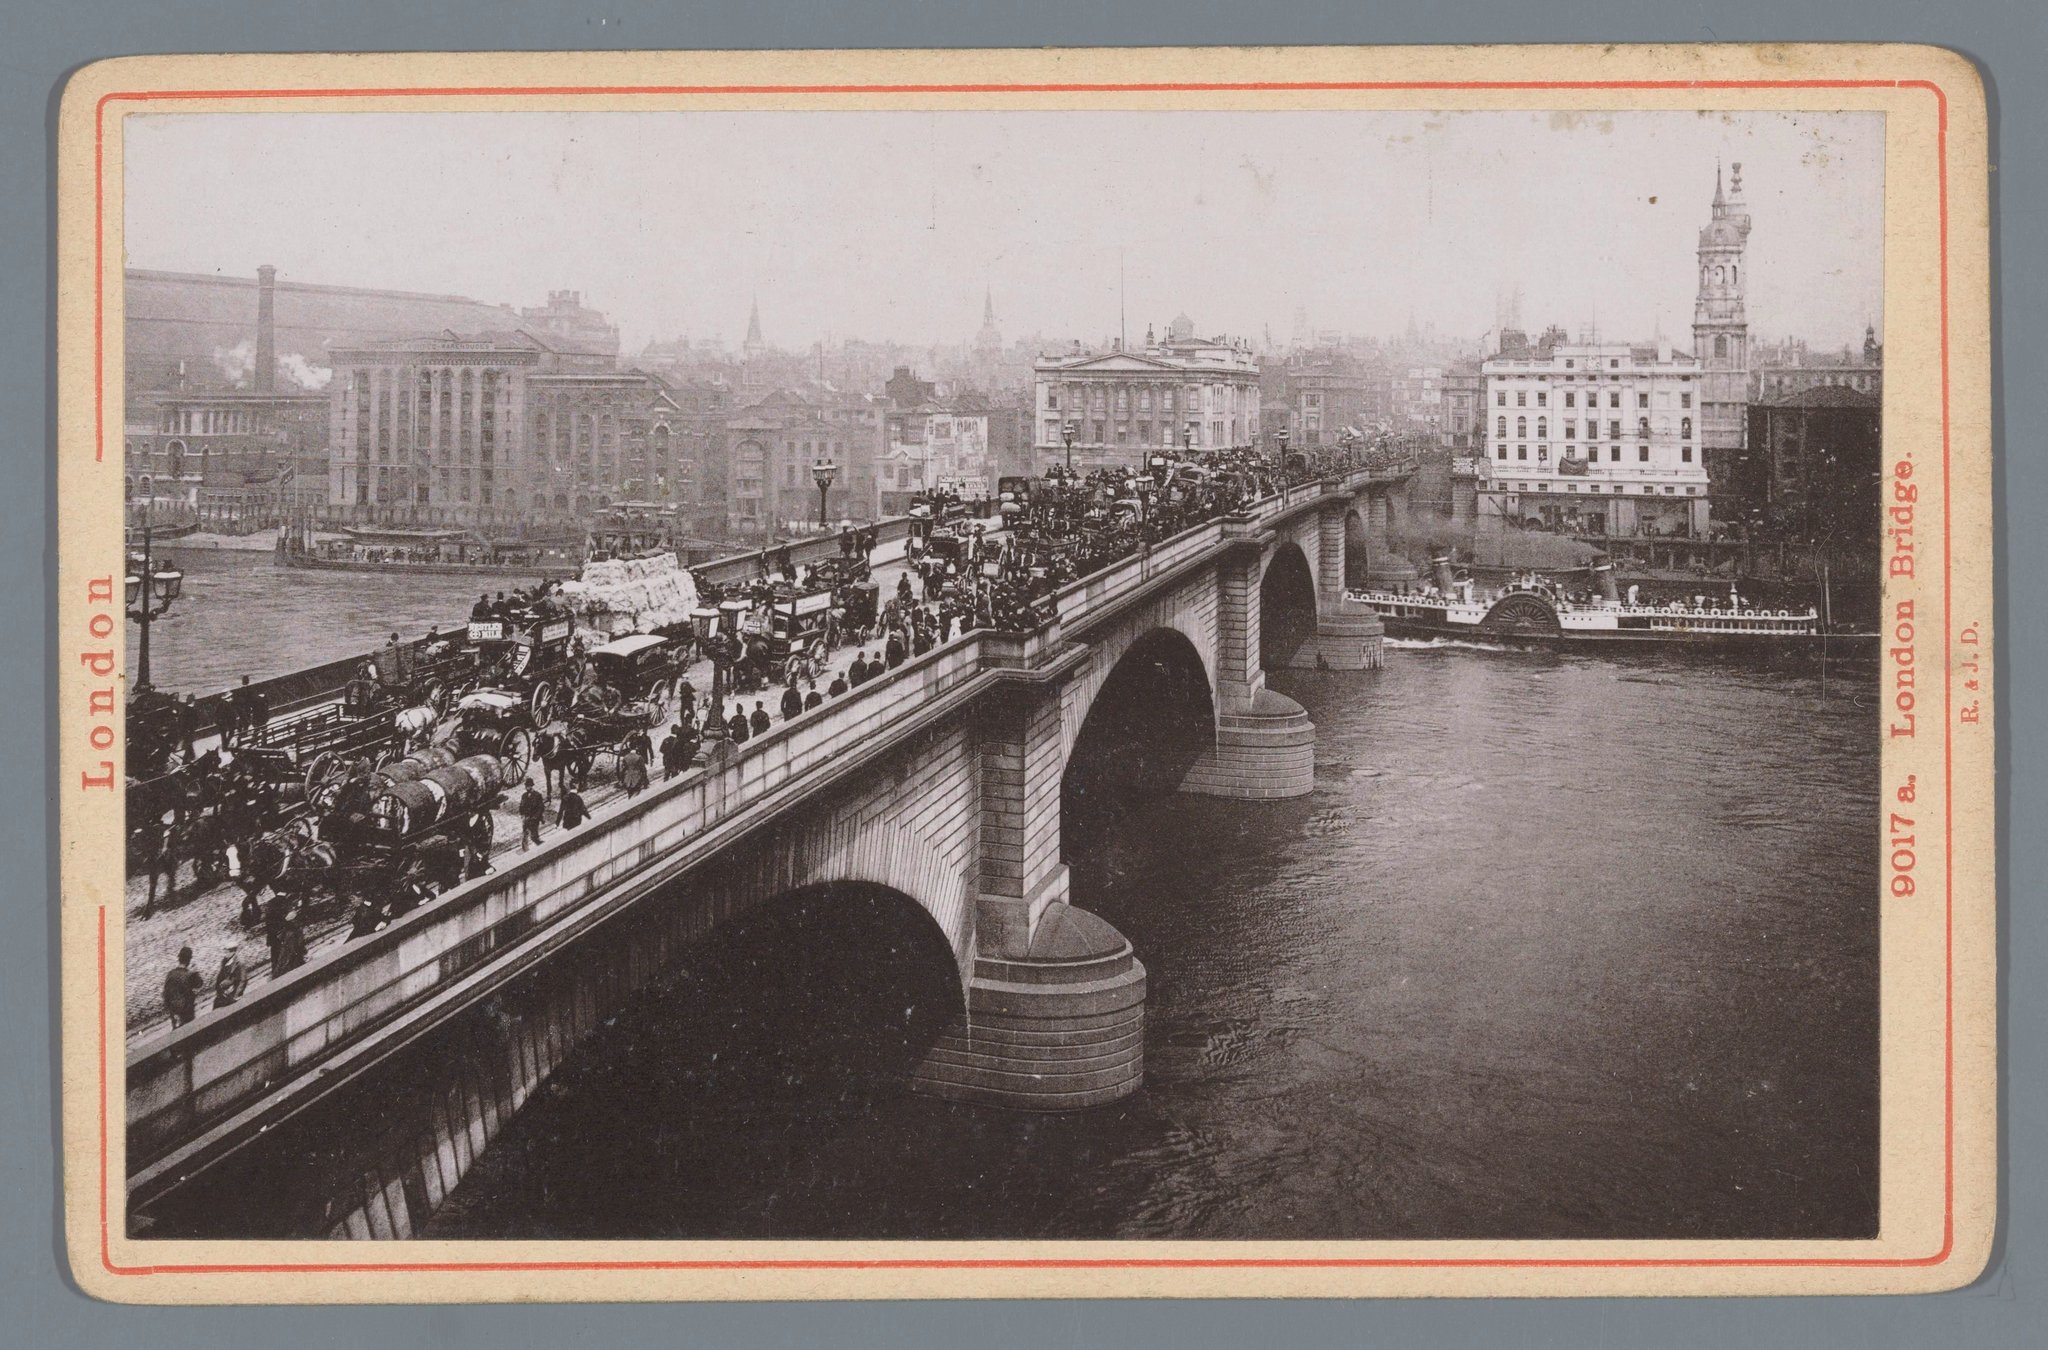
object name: photomechanical print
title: London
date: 1880-1900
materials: cardboard, paper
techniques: photograph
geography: tower bridge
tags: bridge in city across river, canal, etc.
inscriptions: date: ‘29 Septembre 1894’, number: ‘9017 a.’